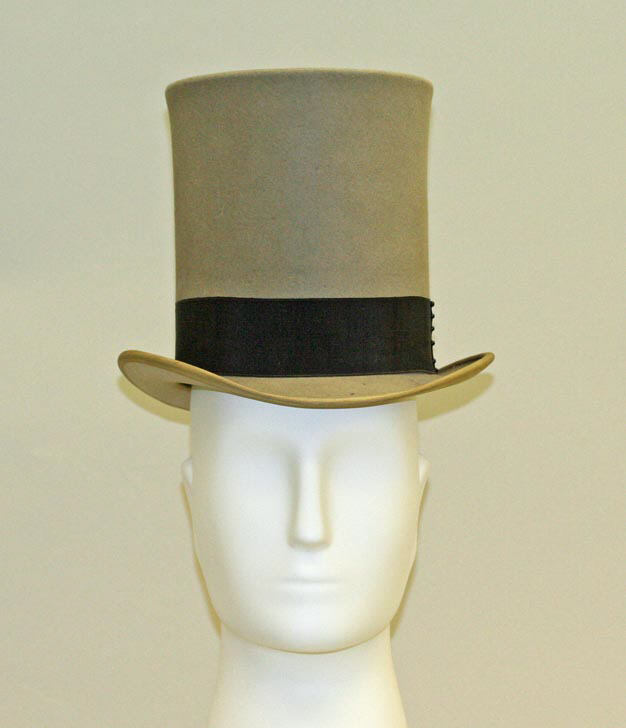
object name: hat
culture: french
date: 1870